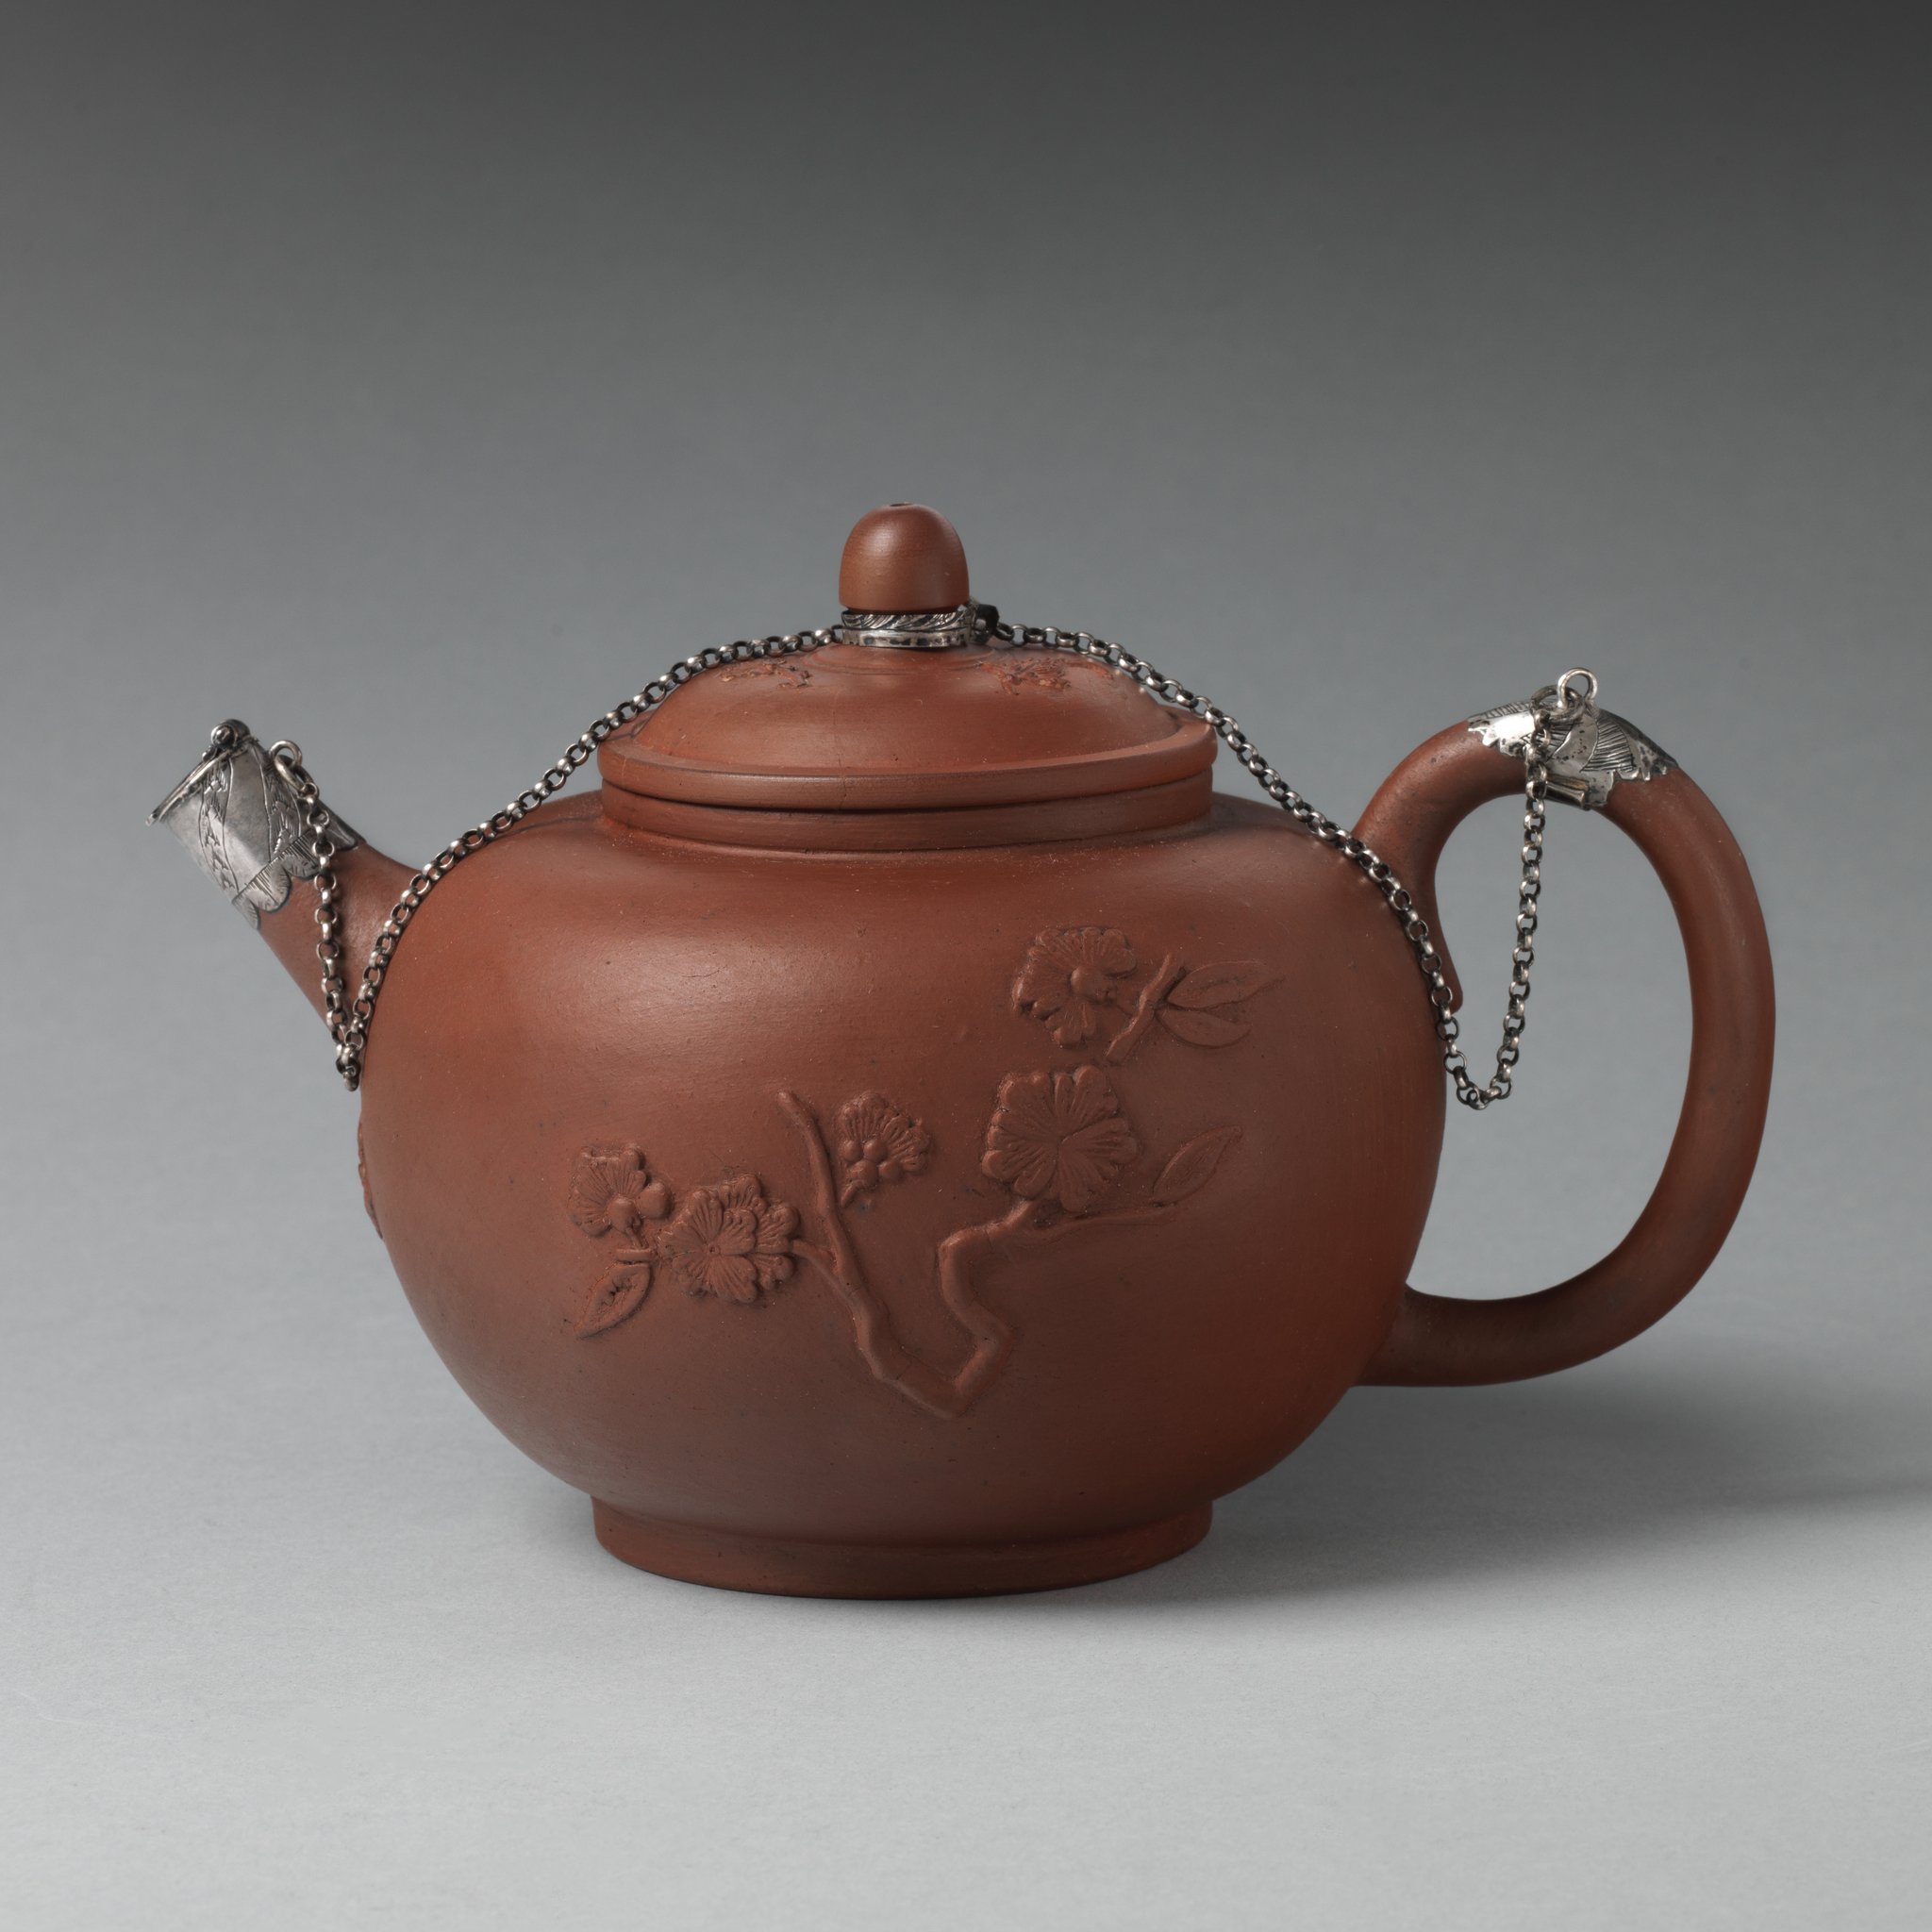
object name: teapot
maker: arij de milde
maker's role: maker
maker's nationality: dutch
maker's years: 1634-1708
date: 1671-1708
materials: earthenware, silver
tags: flowers